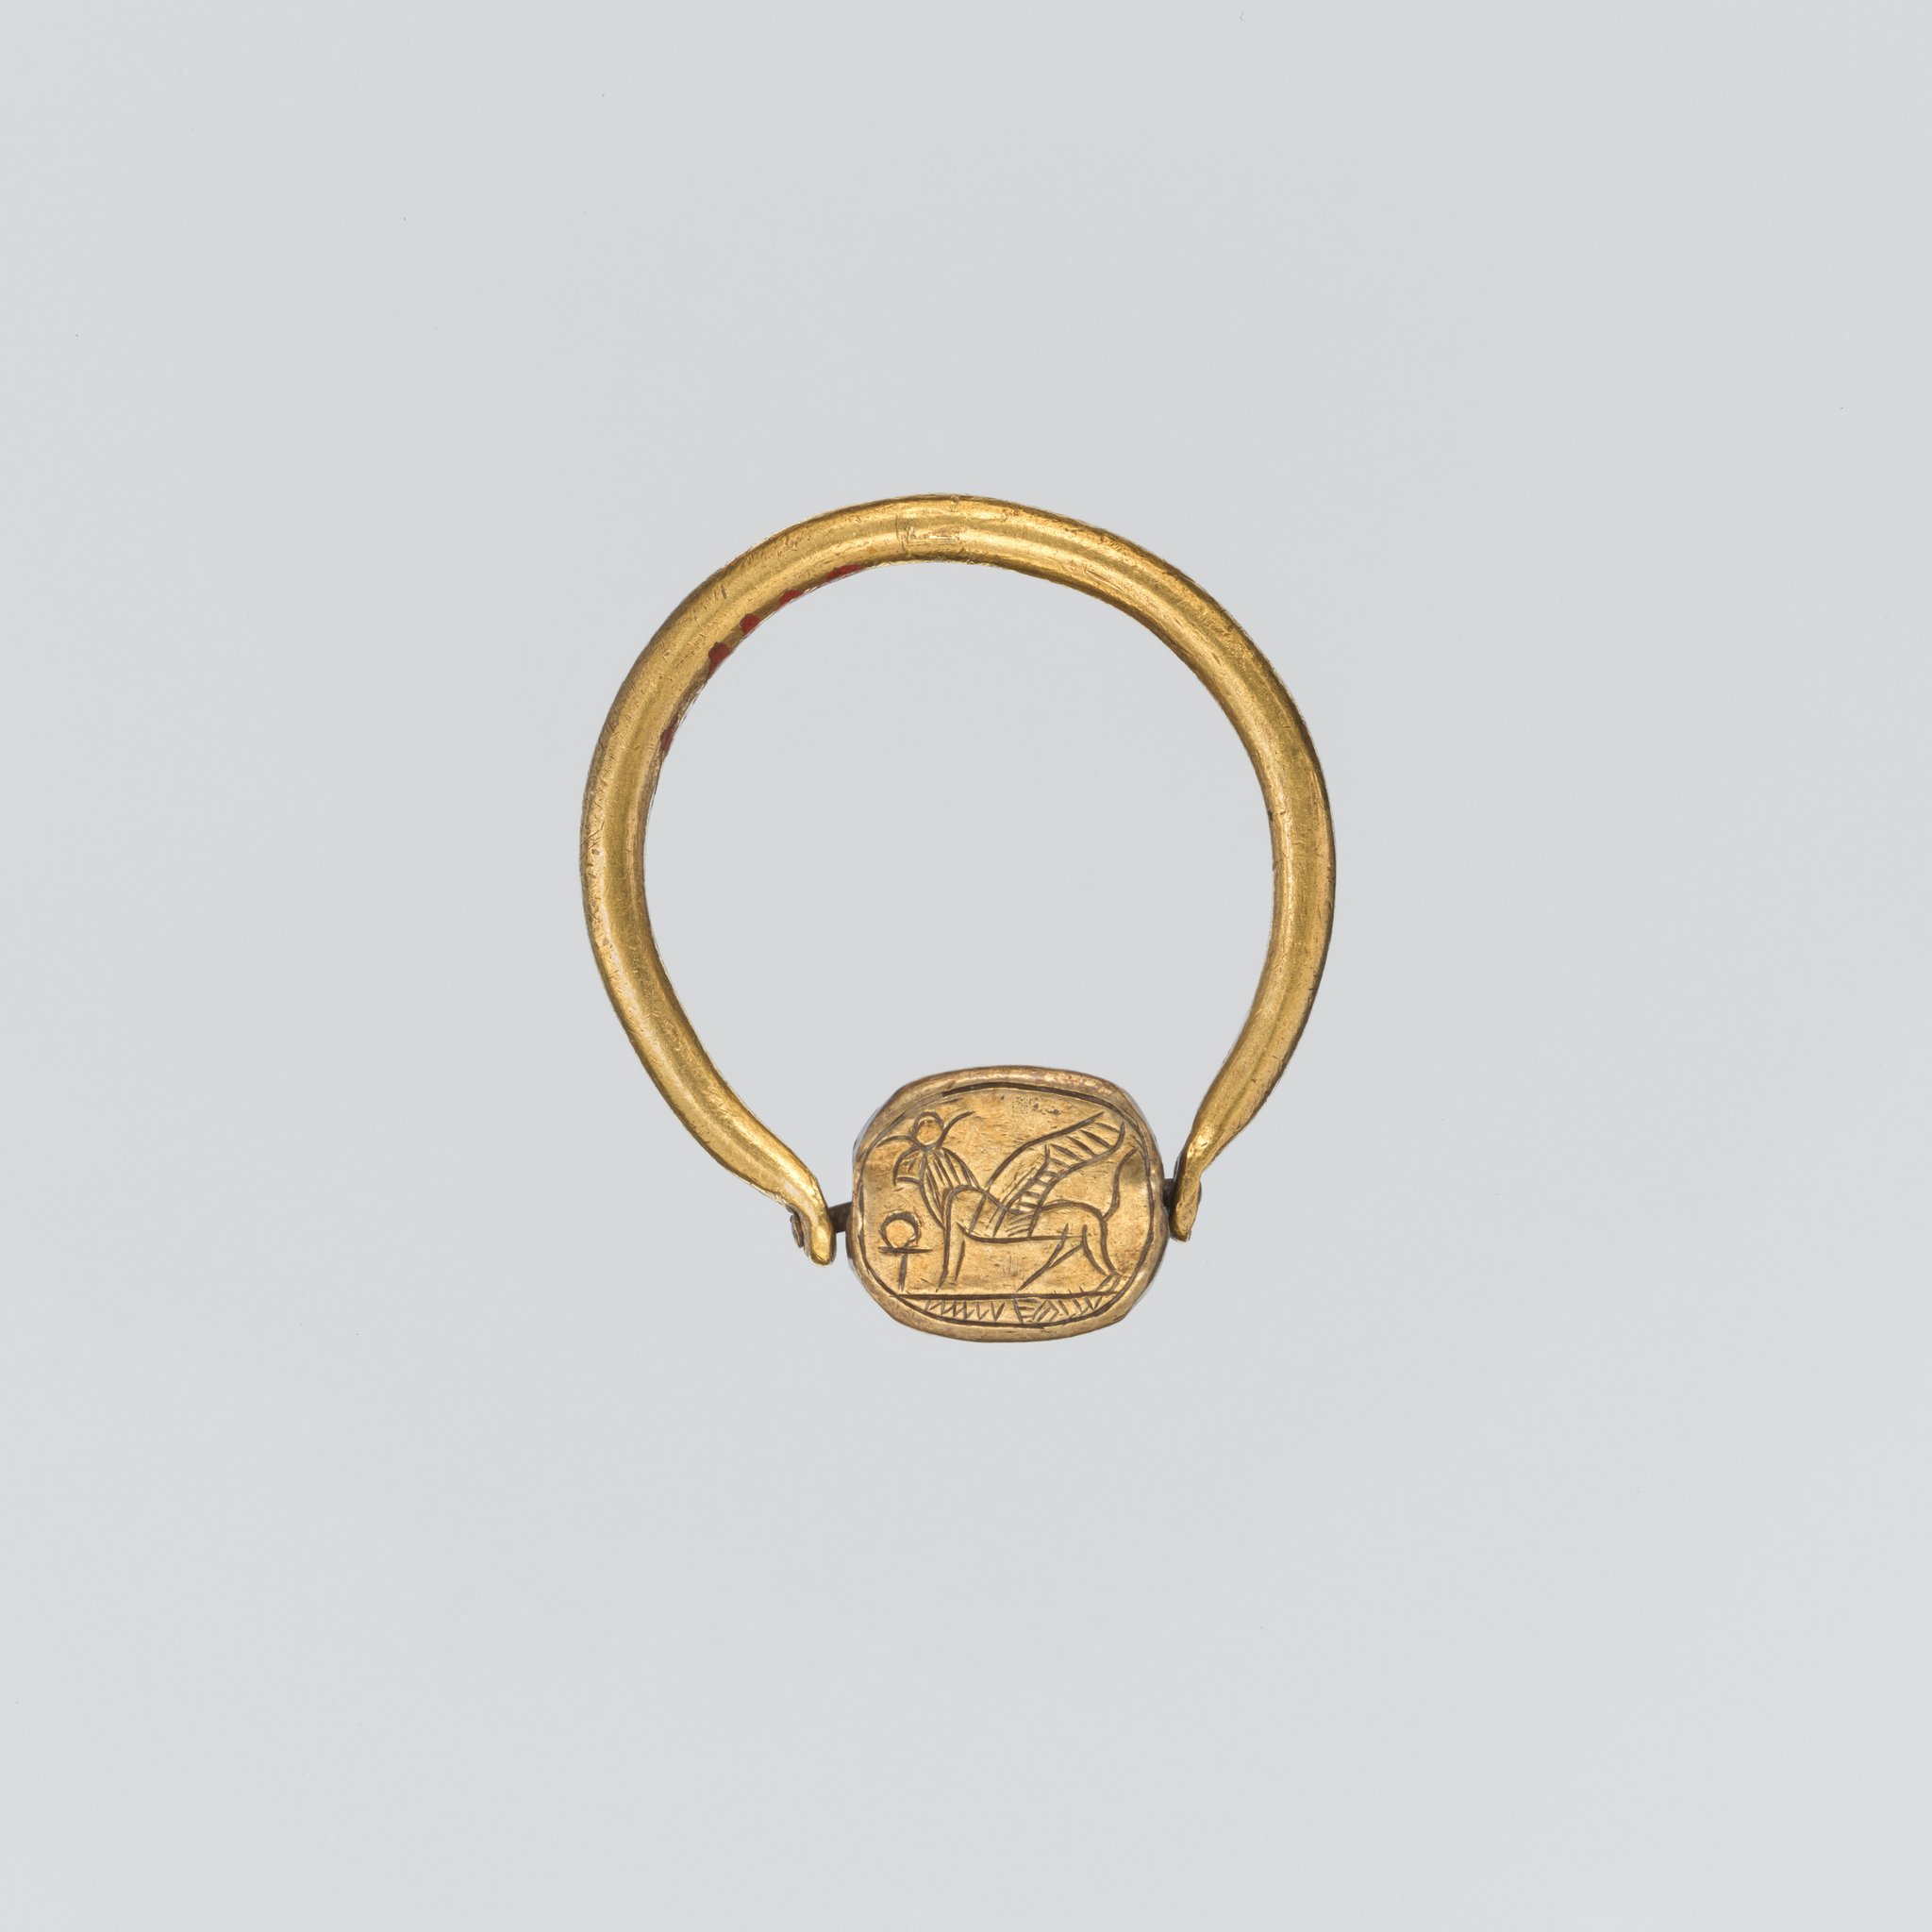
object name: ring with scarab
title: Gold scaraboid ring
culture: cypriot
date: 500-401 BCE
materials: gold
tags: sphinx